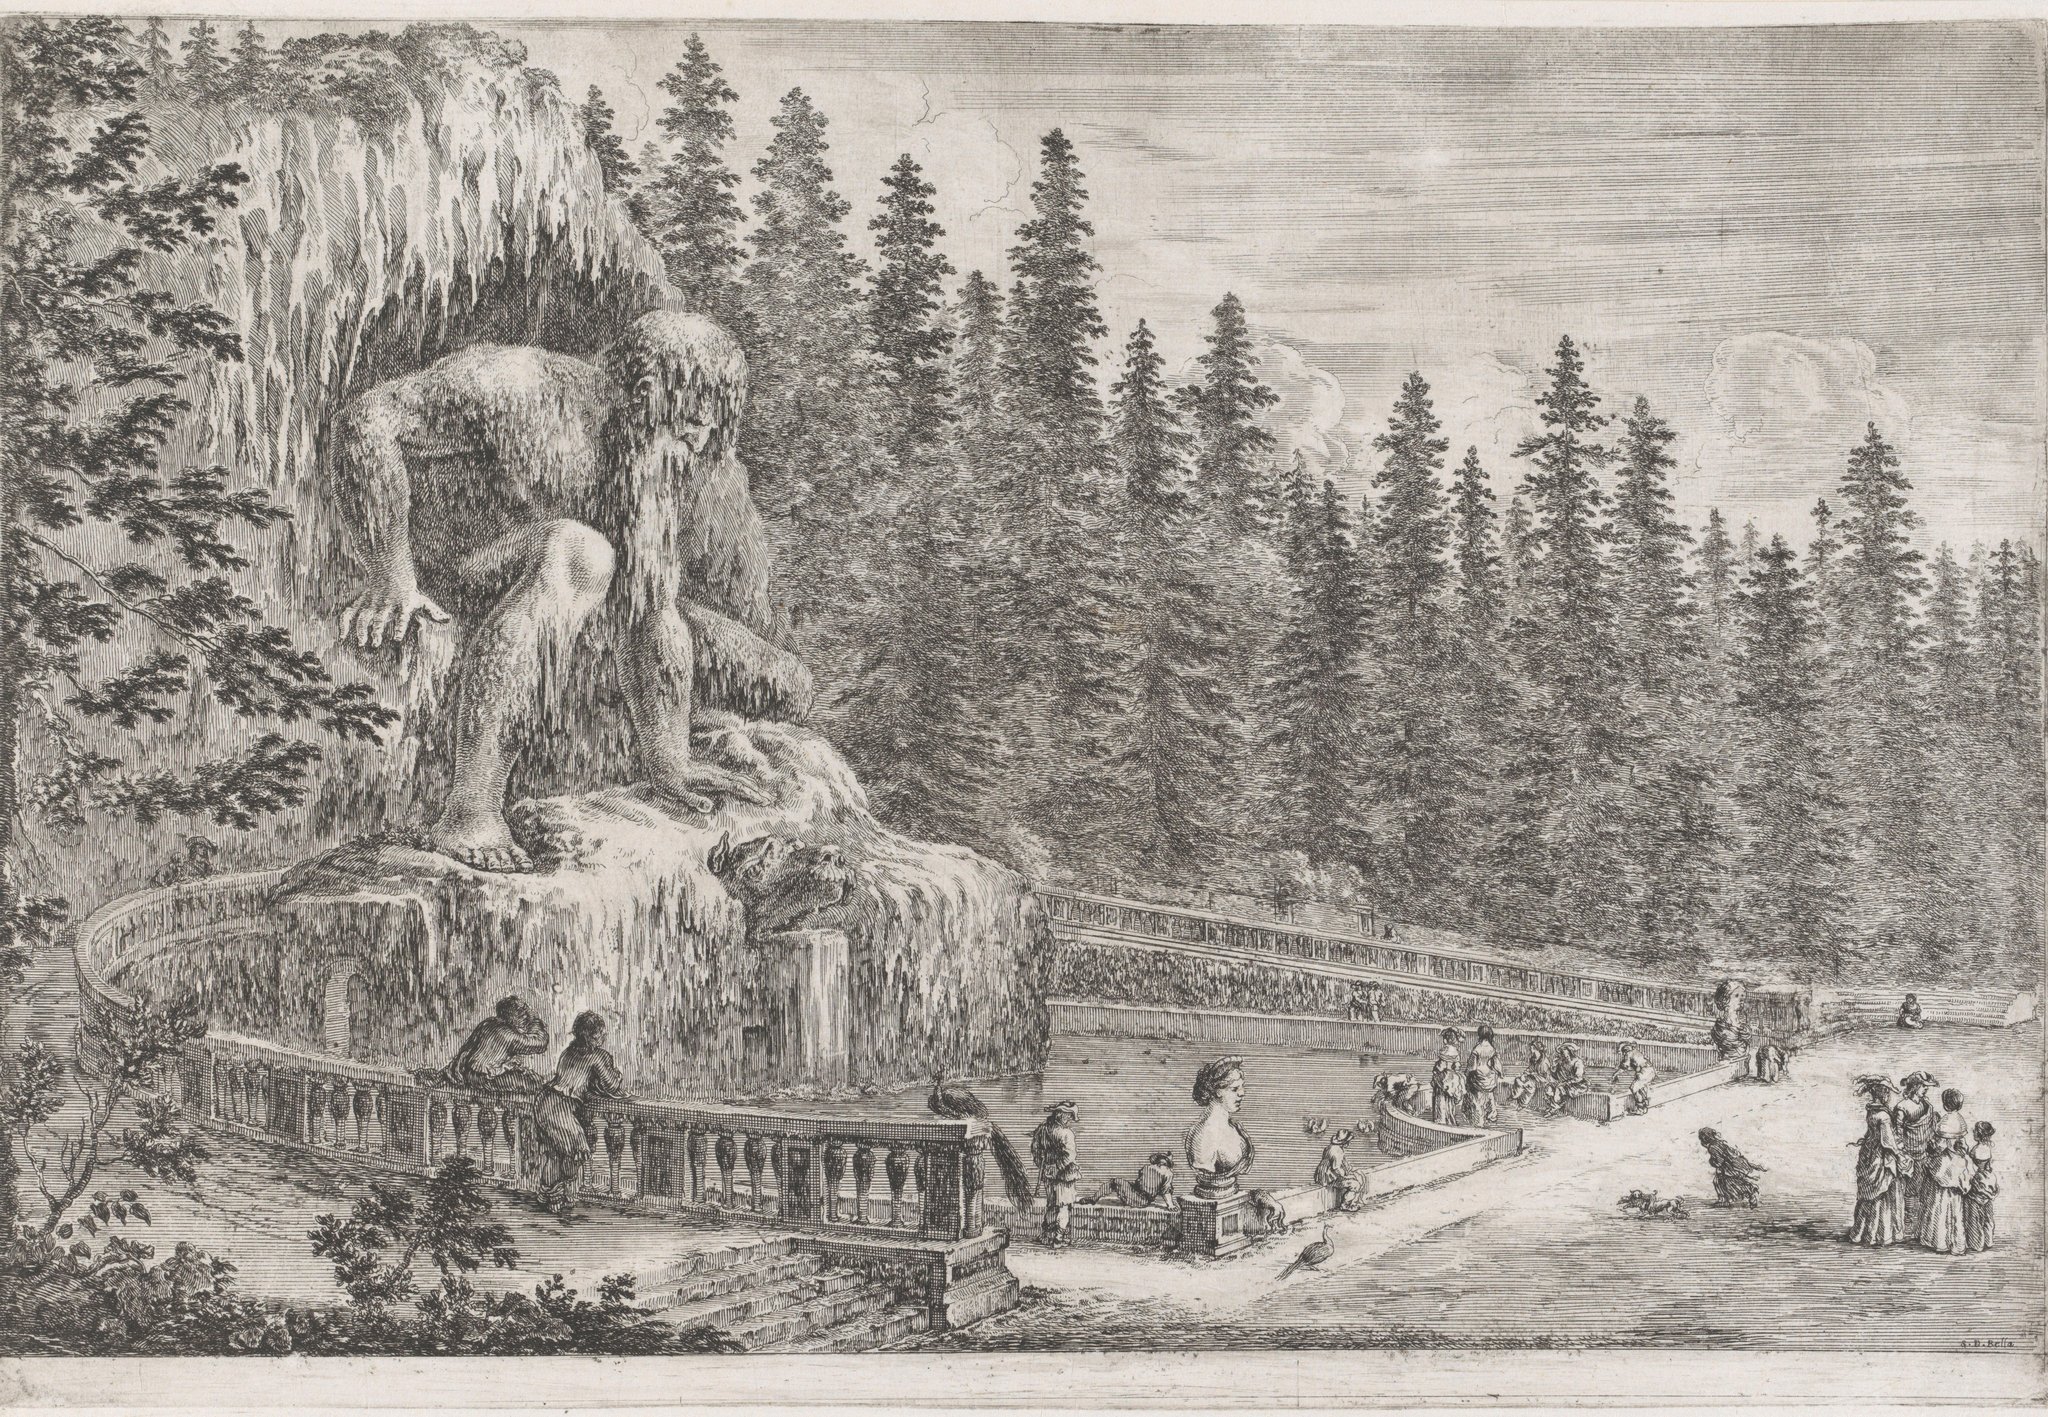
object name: print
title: De Villa Pratolino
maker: stefano della bella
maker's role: draughtsman, print maker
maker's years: 1610-1664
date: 1620-1664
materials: paper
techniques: etching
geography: italy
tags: garden, piece of sculpture, reproduction of a piece of sculpture, giants, colossi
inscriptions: collector's mark: Lugt 240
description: Het sculptuur De Kolos van de Apennijnen (Colosso dell'Appennino) door Giambologna, in de tuin van Villa Pratolino. Een sculptuur van een oude man met baard die losbreekt uit een grot. Hij buigt voorover naar een hondenkop. Uit de hondenkop komt water. Voor het sculptuur een vijver. Verschillende figuren op de voorgrond bij de vijver. Op de achtergrond een dennenbos.